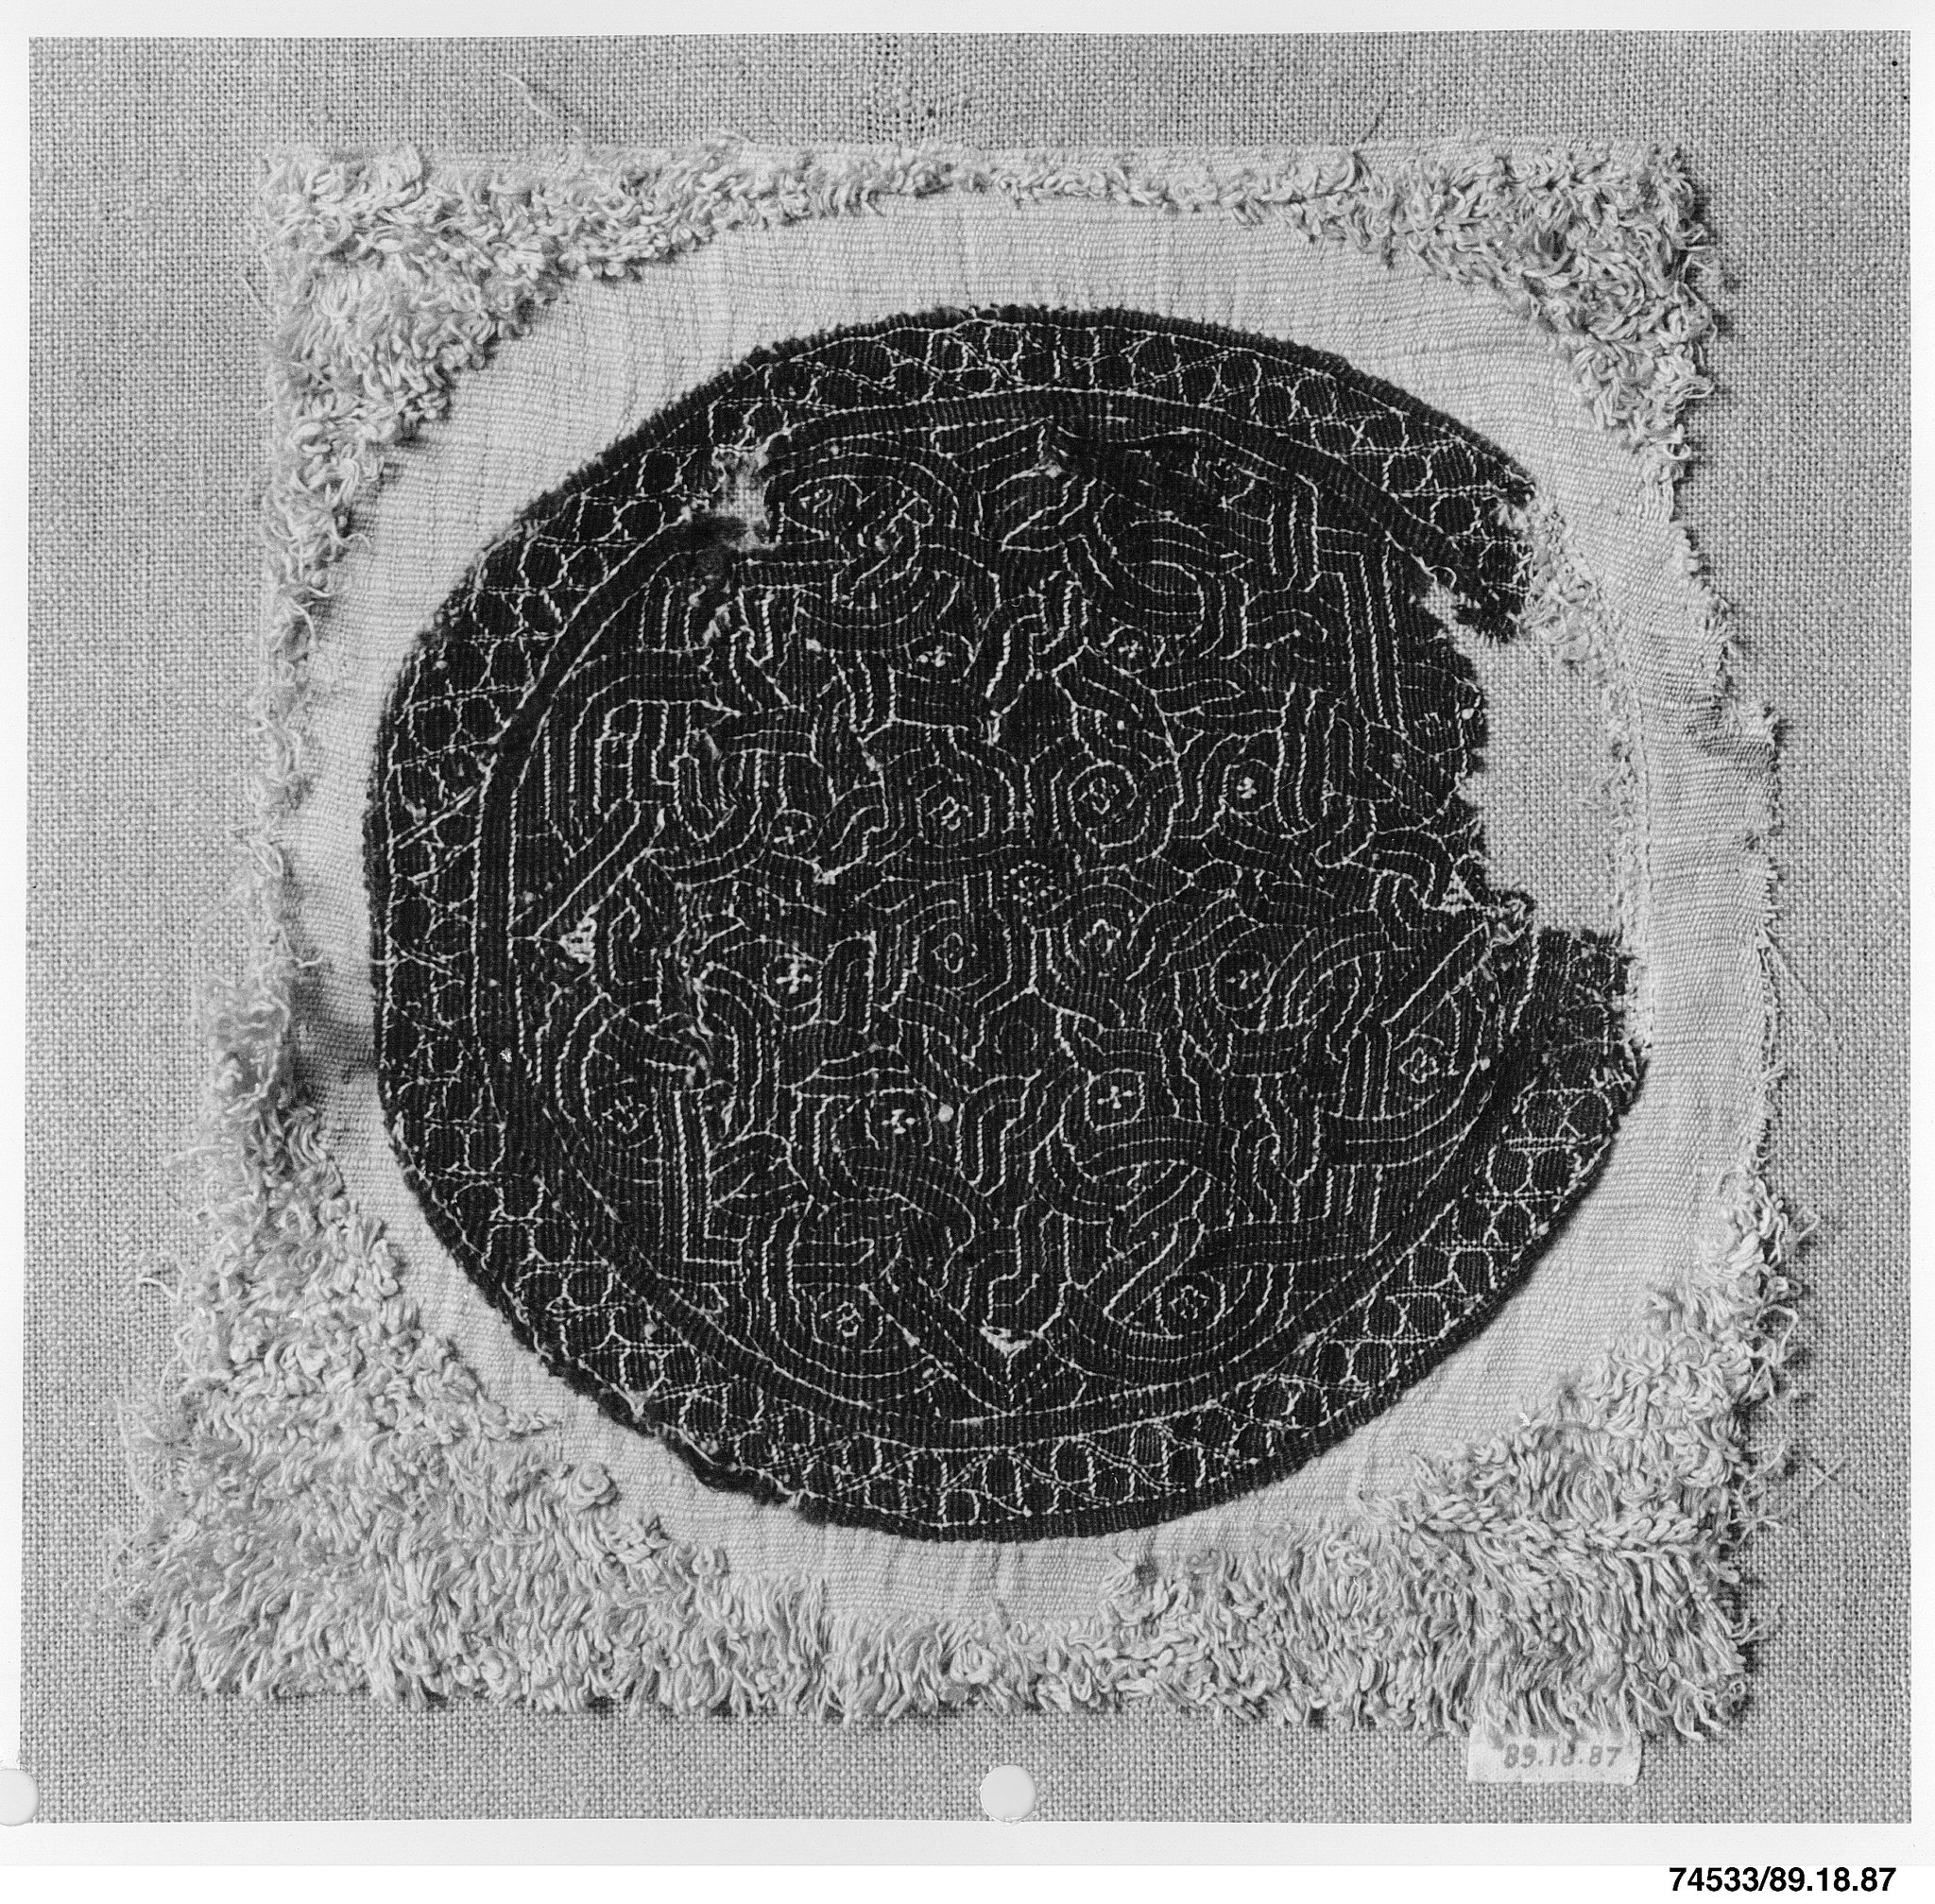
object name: textile fragment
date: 201-400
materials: linen, wool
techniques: weave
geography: egypt